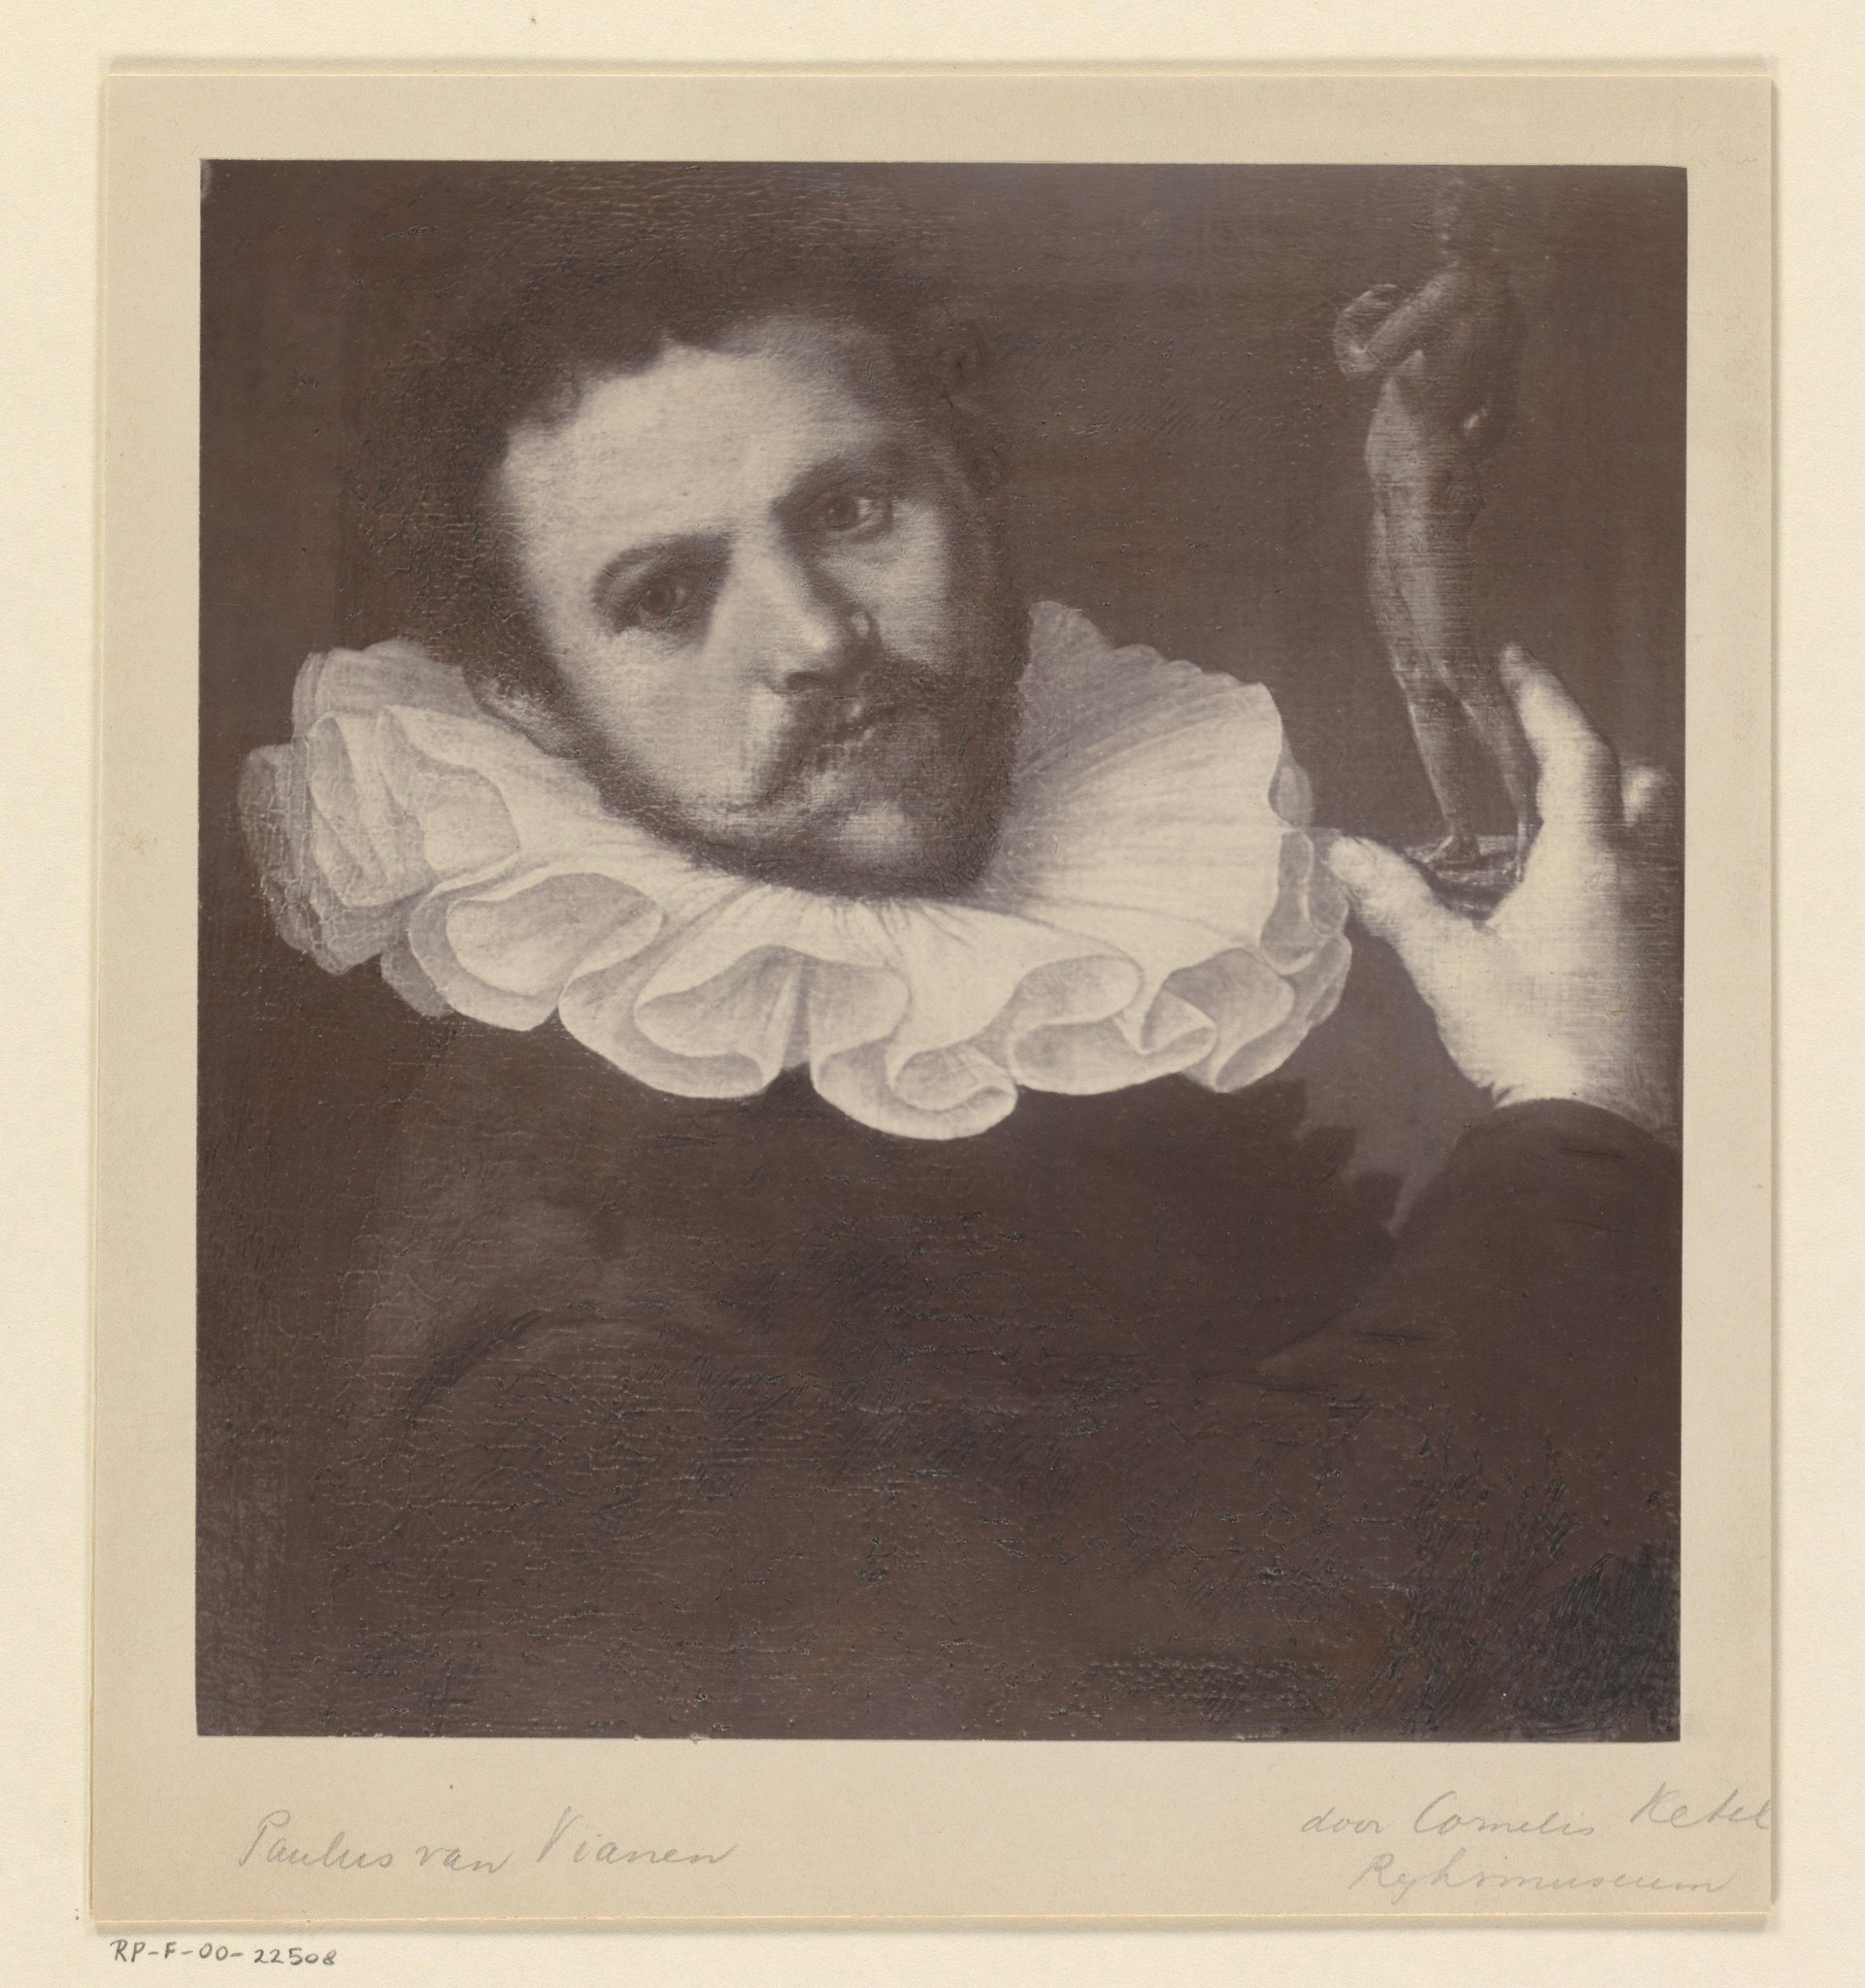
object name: reproduction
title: Paulus van Vianen door Cornelis Ketel, Rijksmuseum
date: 1890-1910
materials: paper, cardboard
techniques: gelatin silver print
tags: prague, draughtsman, jeweler, paulus willemsz. van vianen, historical persons, jeweller, goldsmith, silversmith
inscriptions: collector's mark: Lugt 2228